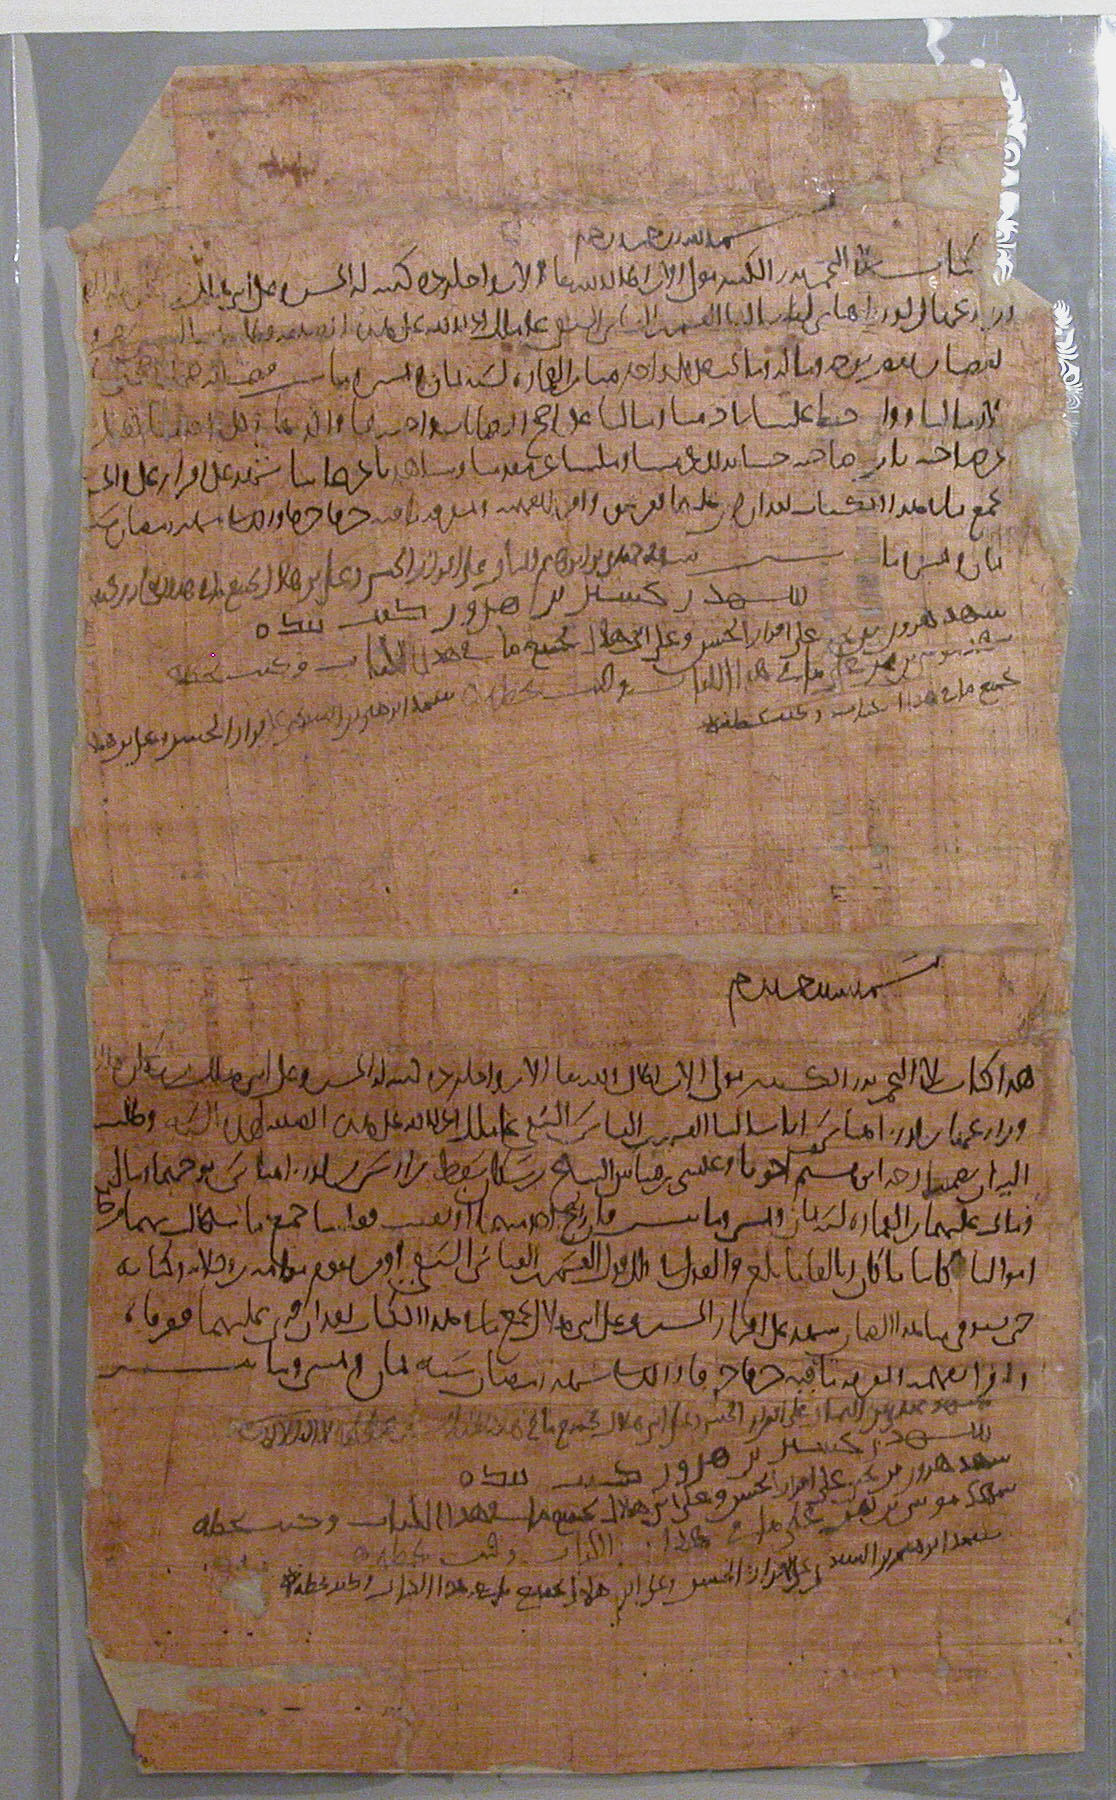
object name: fragment of a non illustrated single work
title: Calligraphic Papyrus Fragments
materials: ink, papyrus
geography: egypt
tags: documents